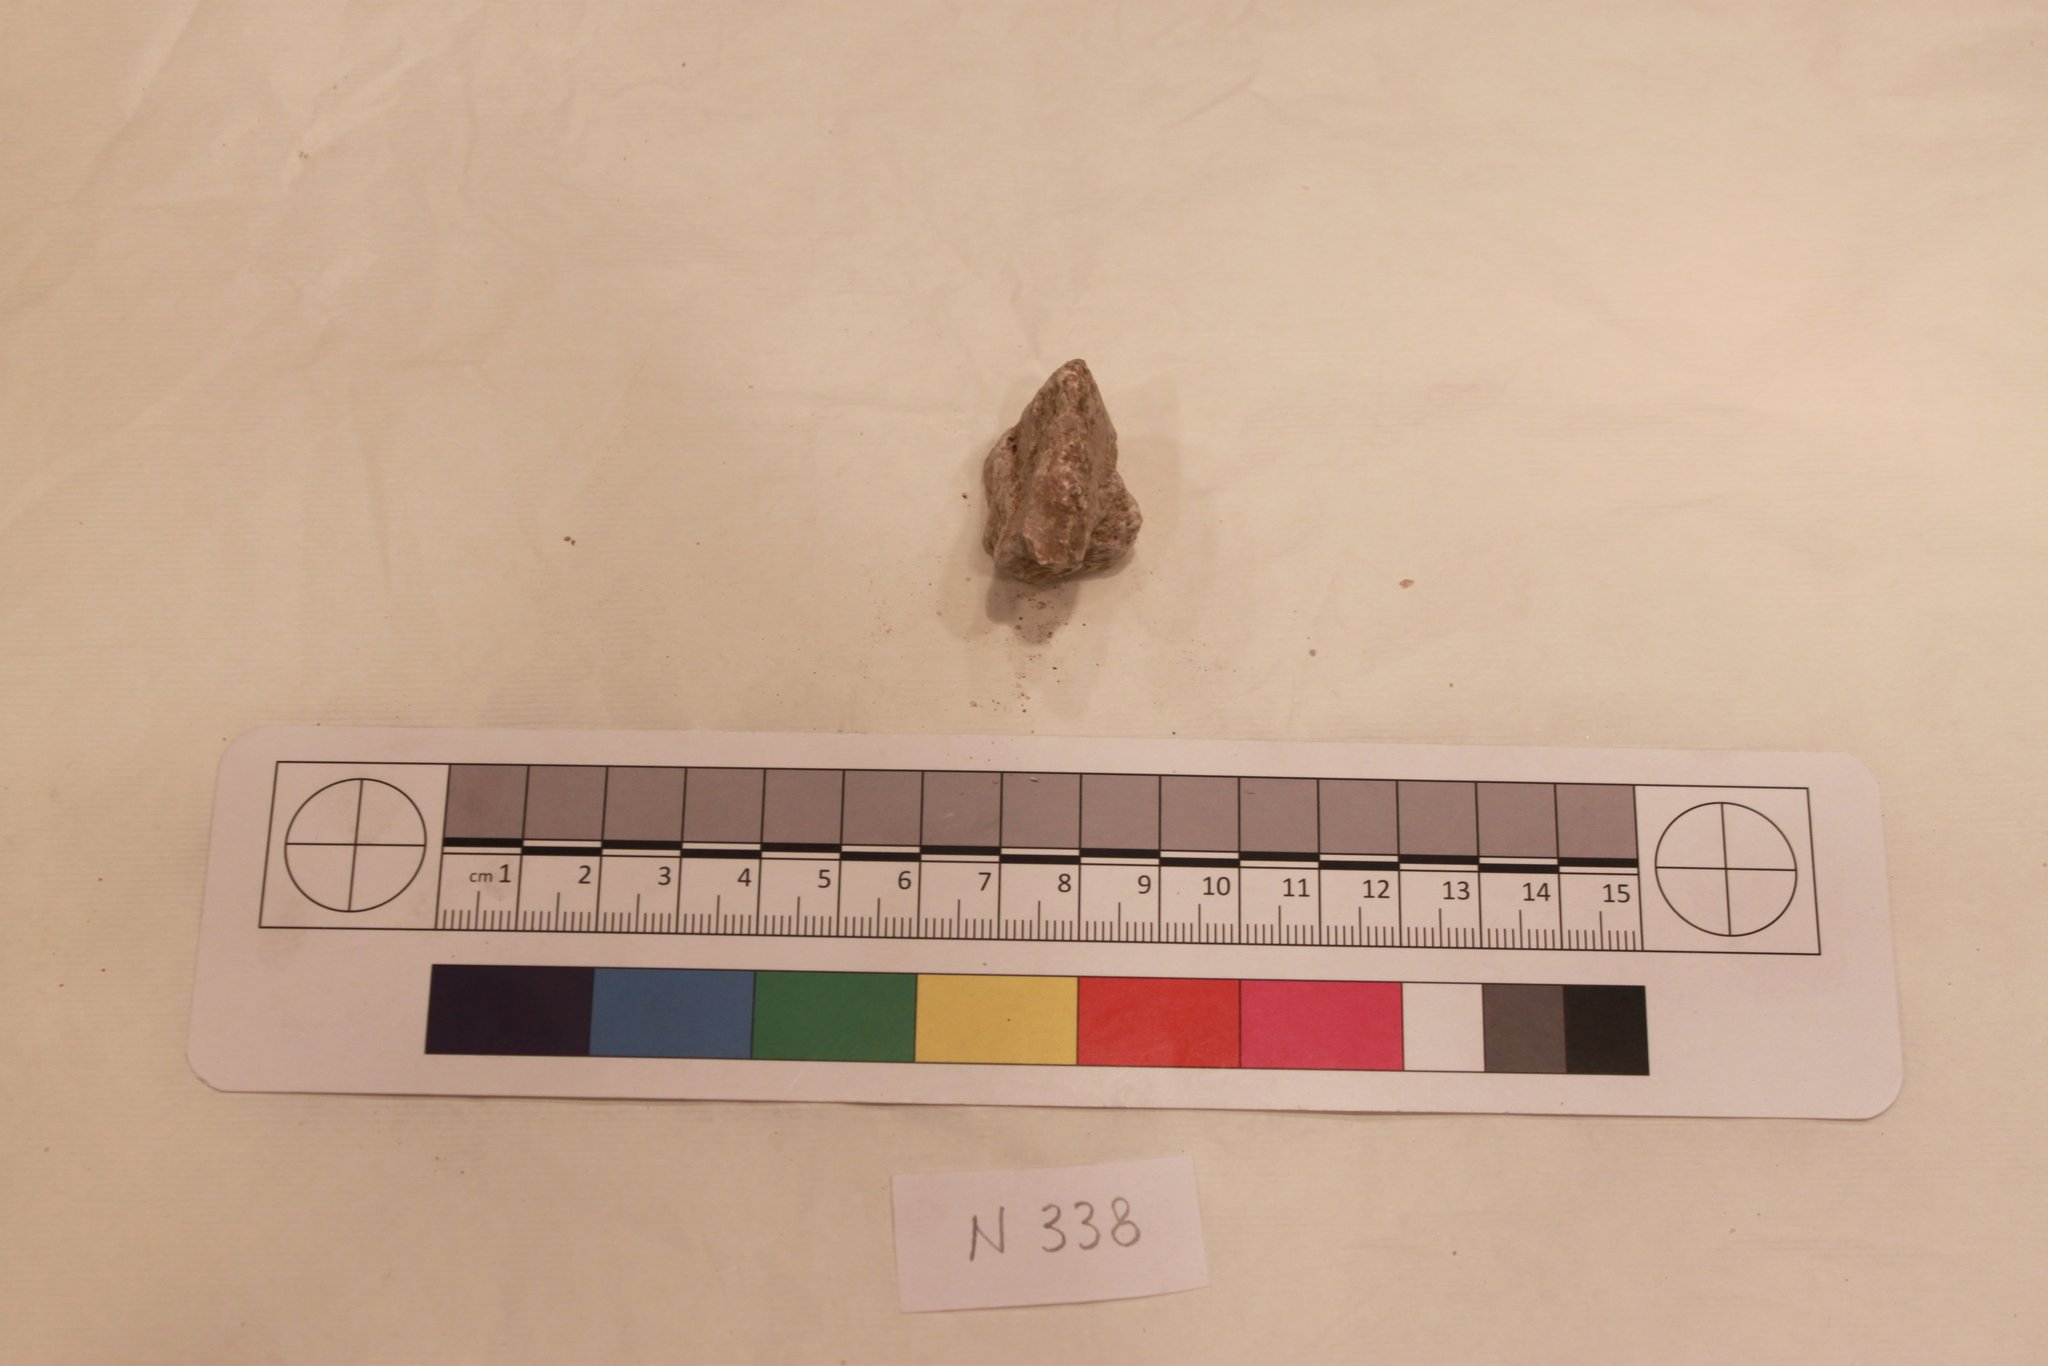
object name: fragment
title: Stucco Fragment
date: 701-1200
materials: plaster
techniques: carving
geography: iran